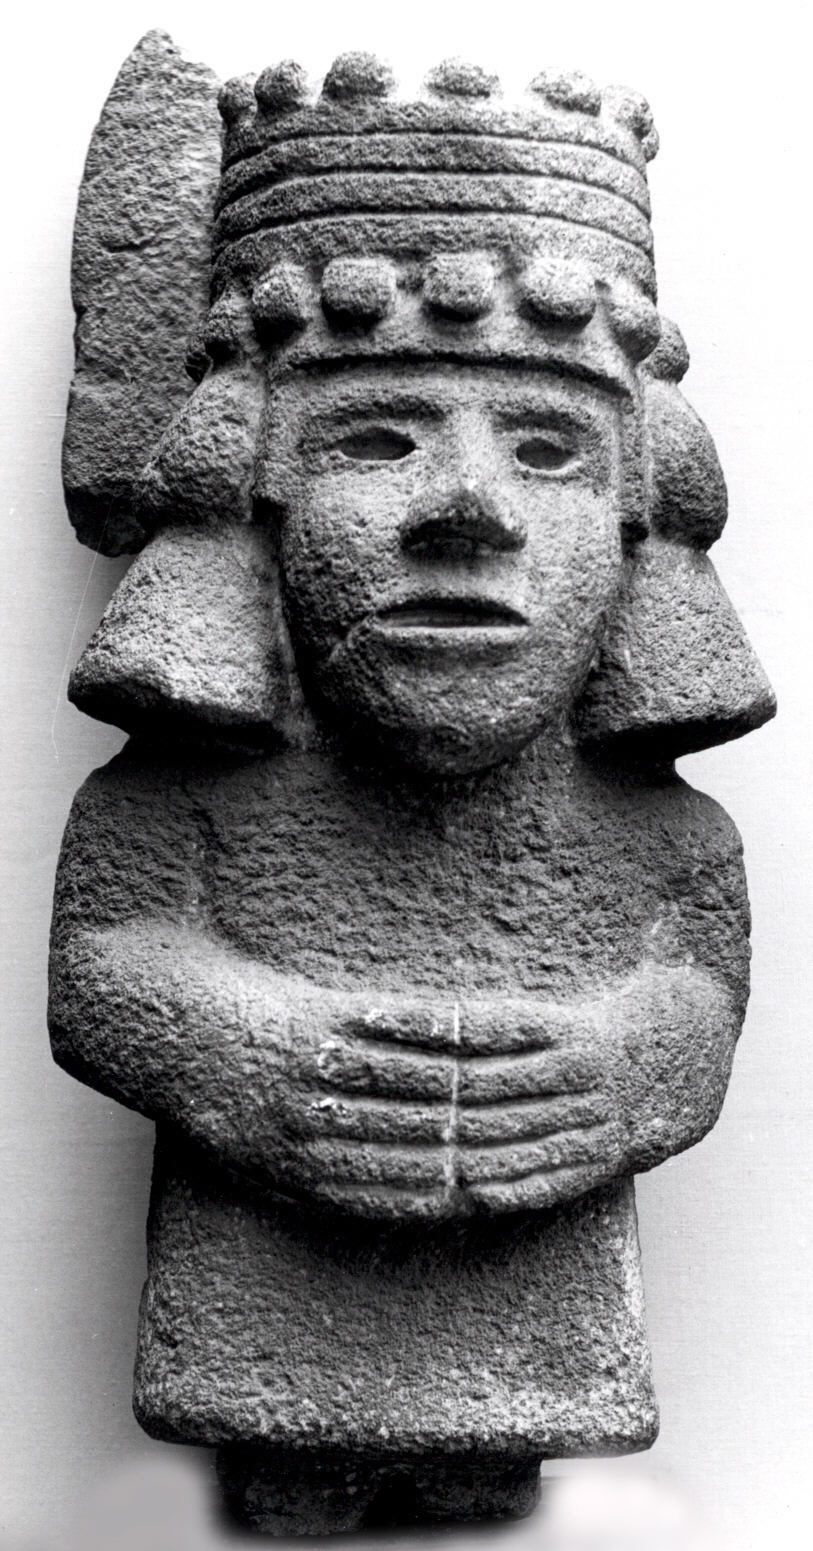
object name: figure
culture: mexica, aztec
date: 1301-1433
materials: stone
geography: mexico